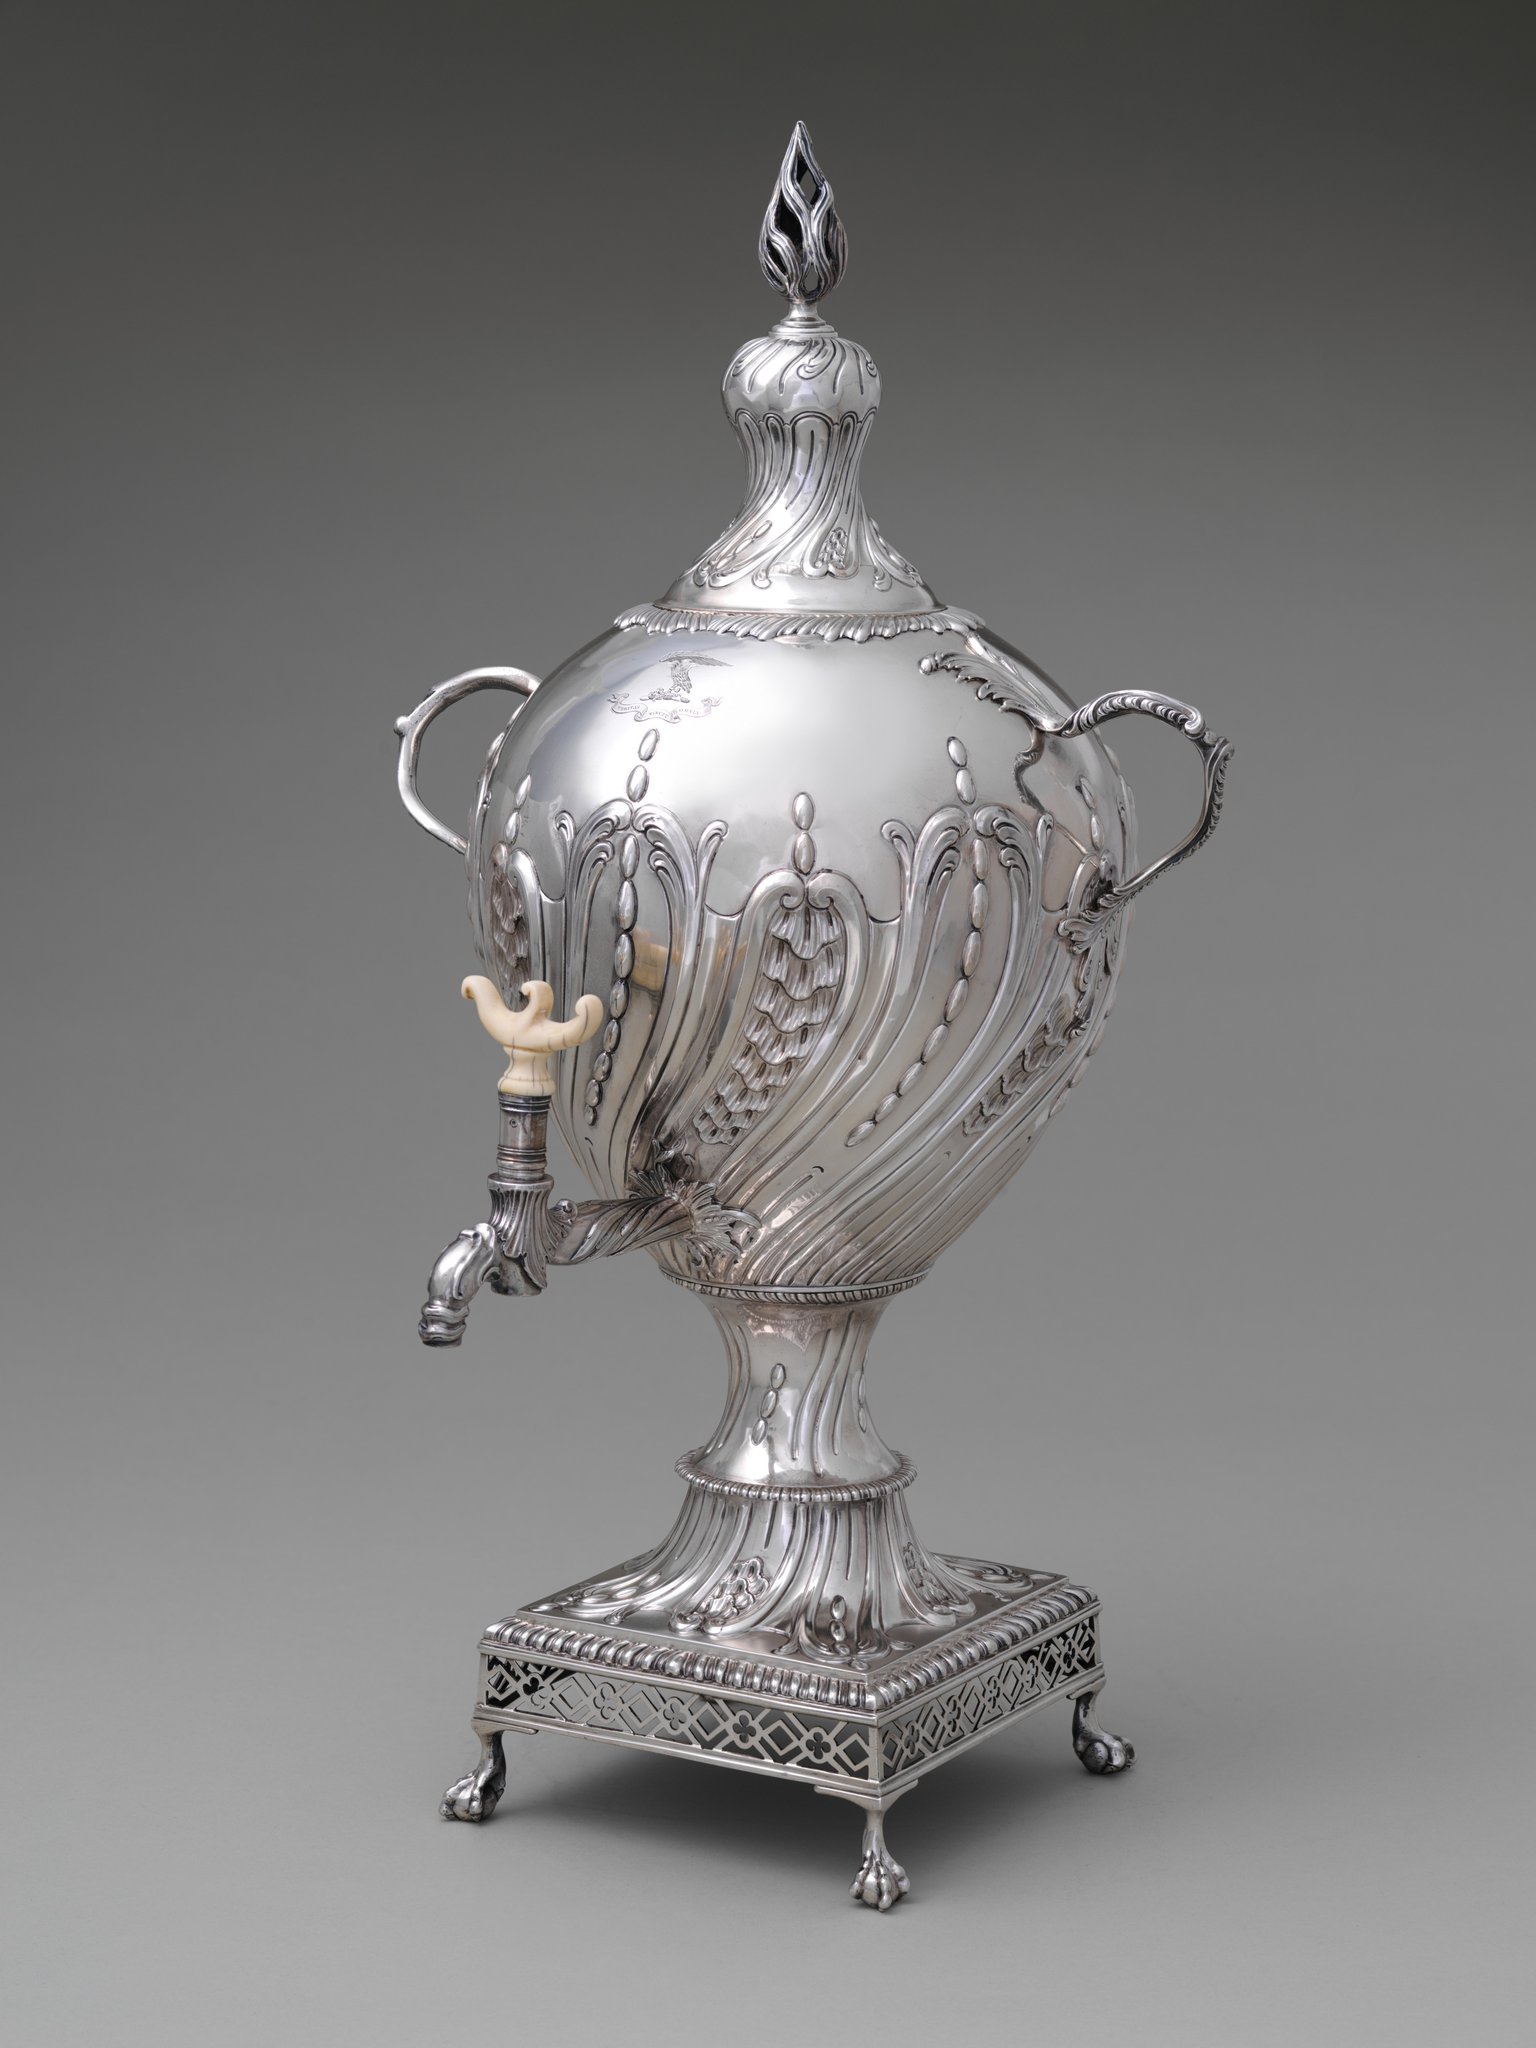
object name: hot water urn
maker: louisa courtauld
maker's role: maker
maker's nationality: british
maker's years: 1729-1807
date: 1765-1766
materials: ivory, silver